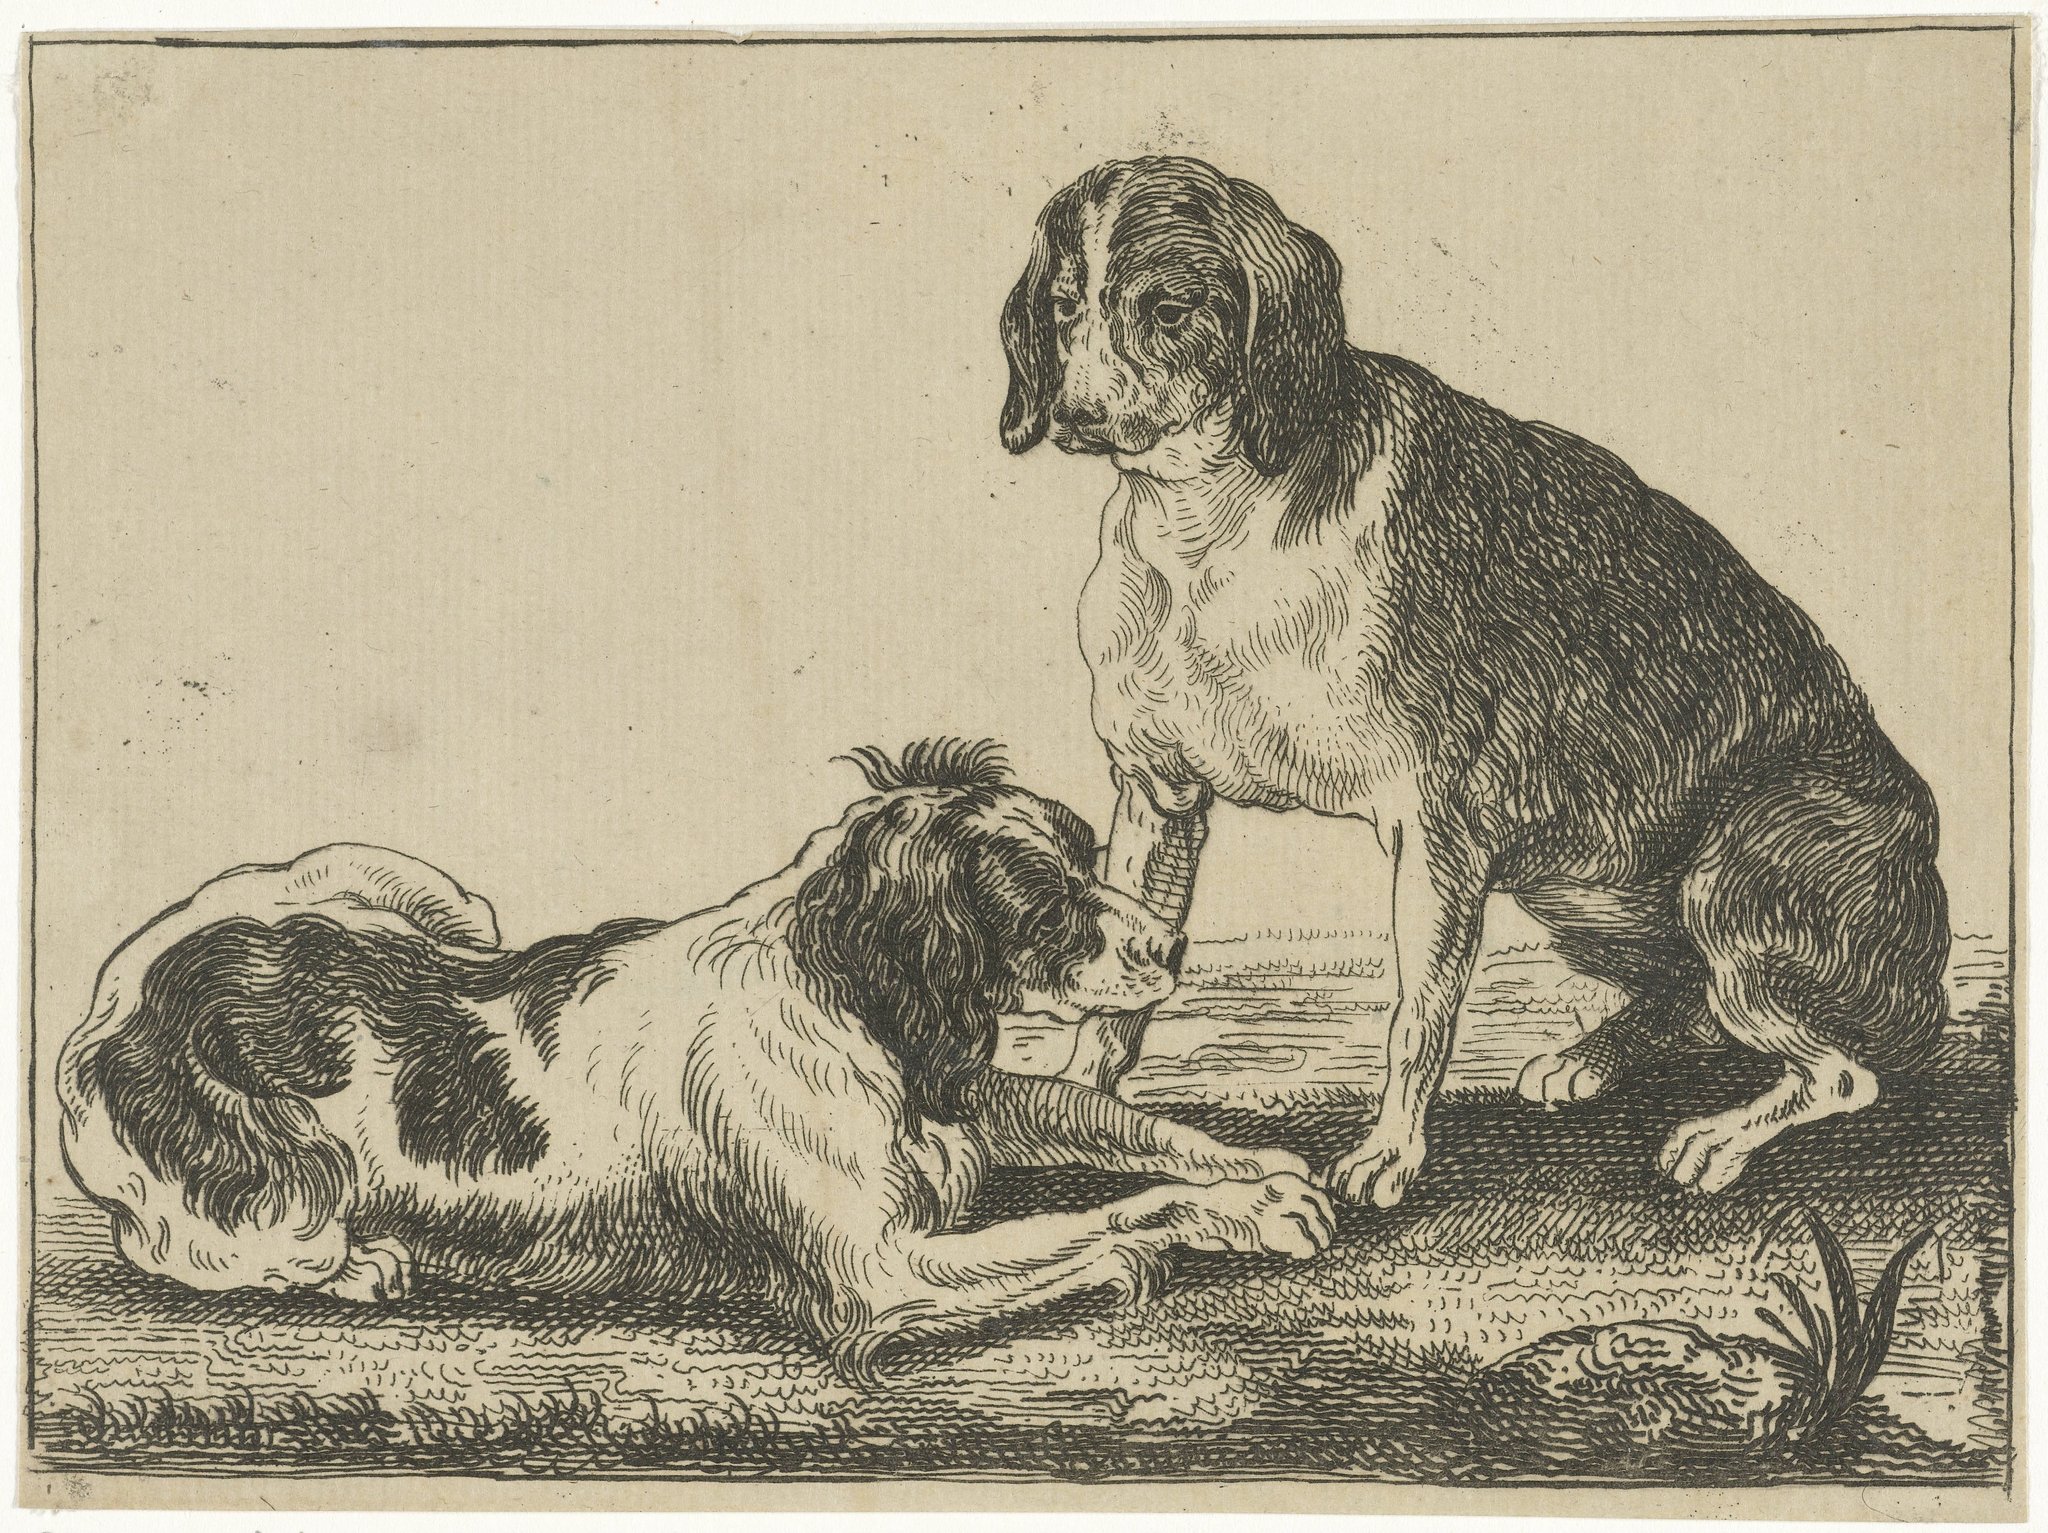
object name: print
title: Twee rustende honden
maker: Anonymous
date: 1656-1734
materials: paper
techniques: etching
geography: brussels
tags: dog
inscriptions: collector's mark: Lugt 2228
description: Kopie in spiegelbeeld naar de gelijknamige prent uit de serie van twaalf prenten met voorstellingen van dieren van Jan van den Hecke I.